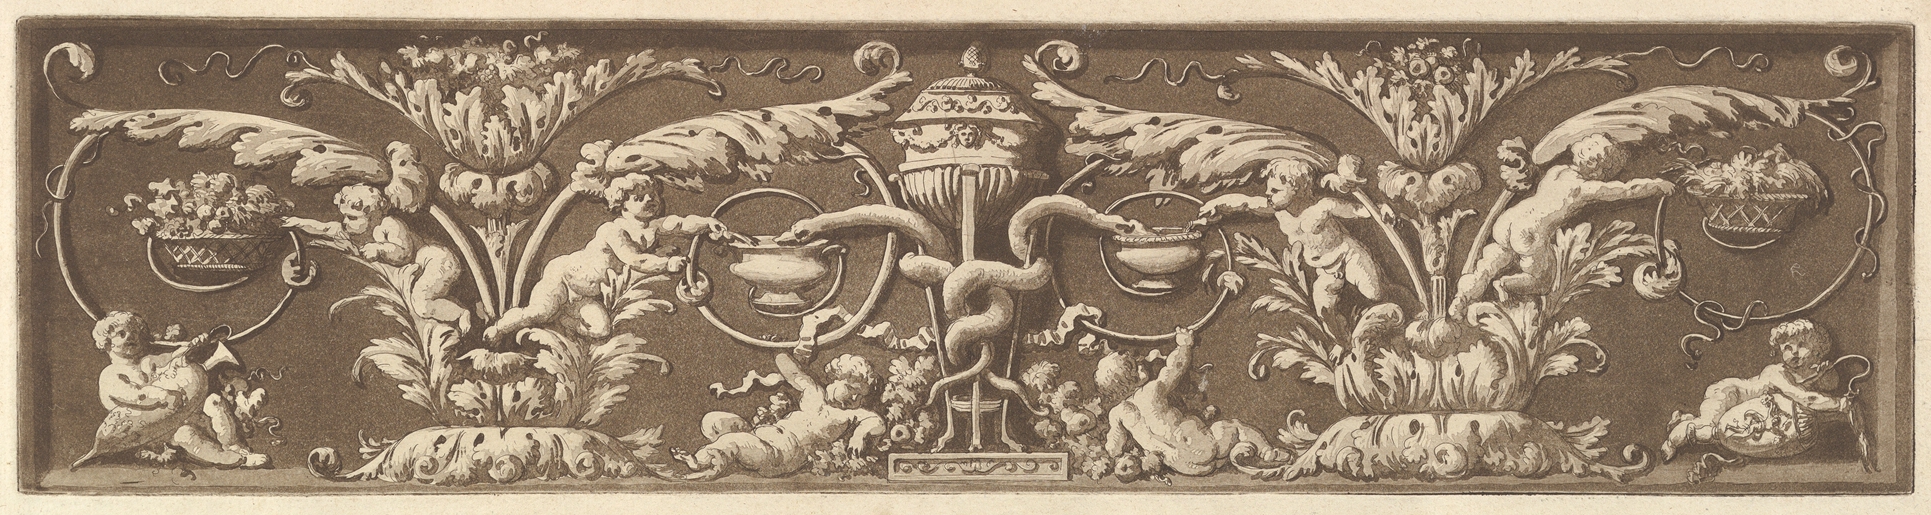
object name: print collection ornament architecture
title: Ornamental frieze with putti and intertwined snakes, from Recueil de Différentes Compositions Frises et Ornements dessinées et gravées à la manière du lavis par La Grenée le Juene Se trouve chez l'Auteur, au Louvre et chez Basan, rue et Hôtel Serpente A Paris, in an album containing Recueil de Compositions par Lagrenée Le Jeune (Collection of Compositions by Lagrenée the Younger)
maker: jean jacques lagrenée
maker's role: artist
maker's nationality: french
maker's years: 1739-1821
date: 1784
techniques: aquatint, etching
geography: france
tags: ornament,putti,snakes